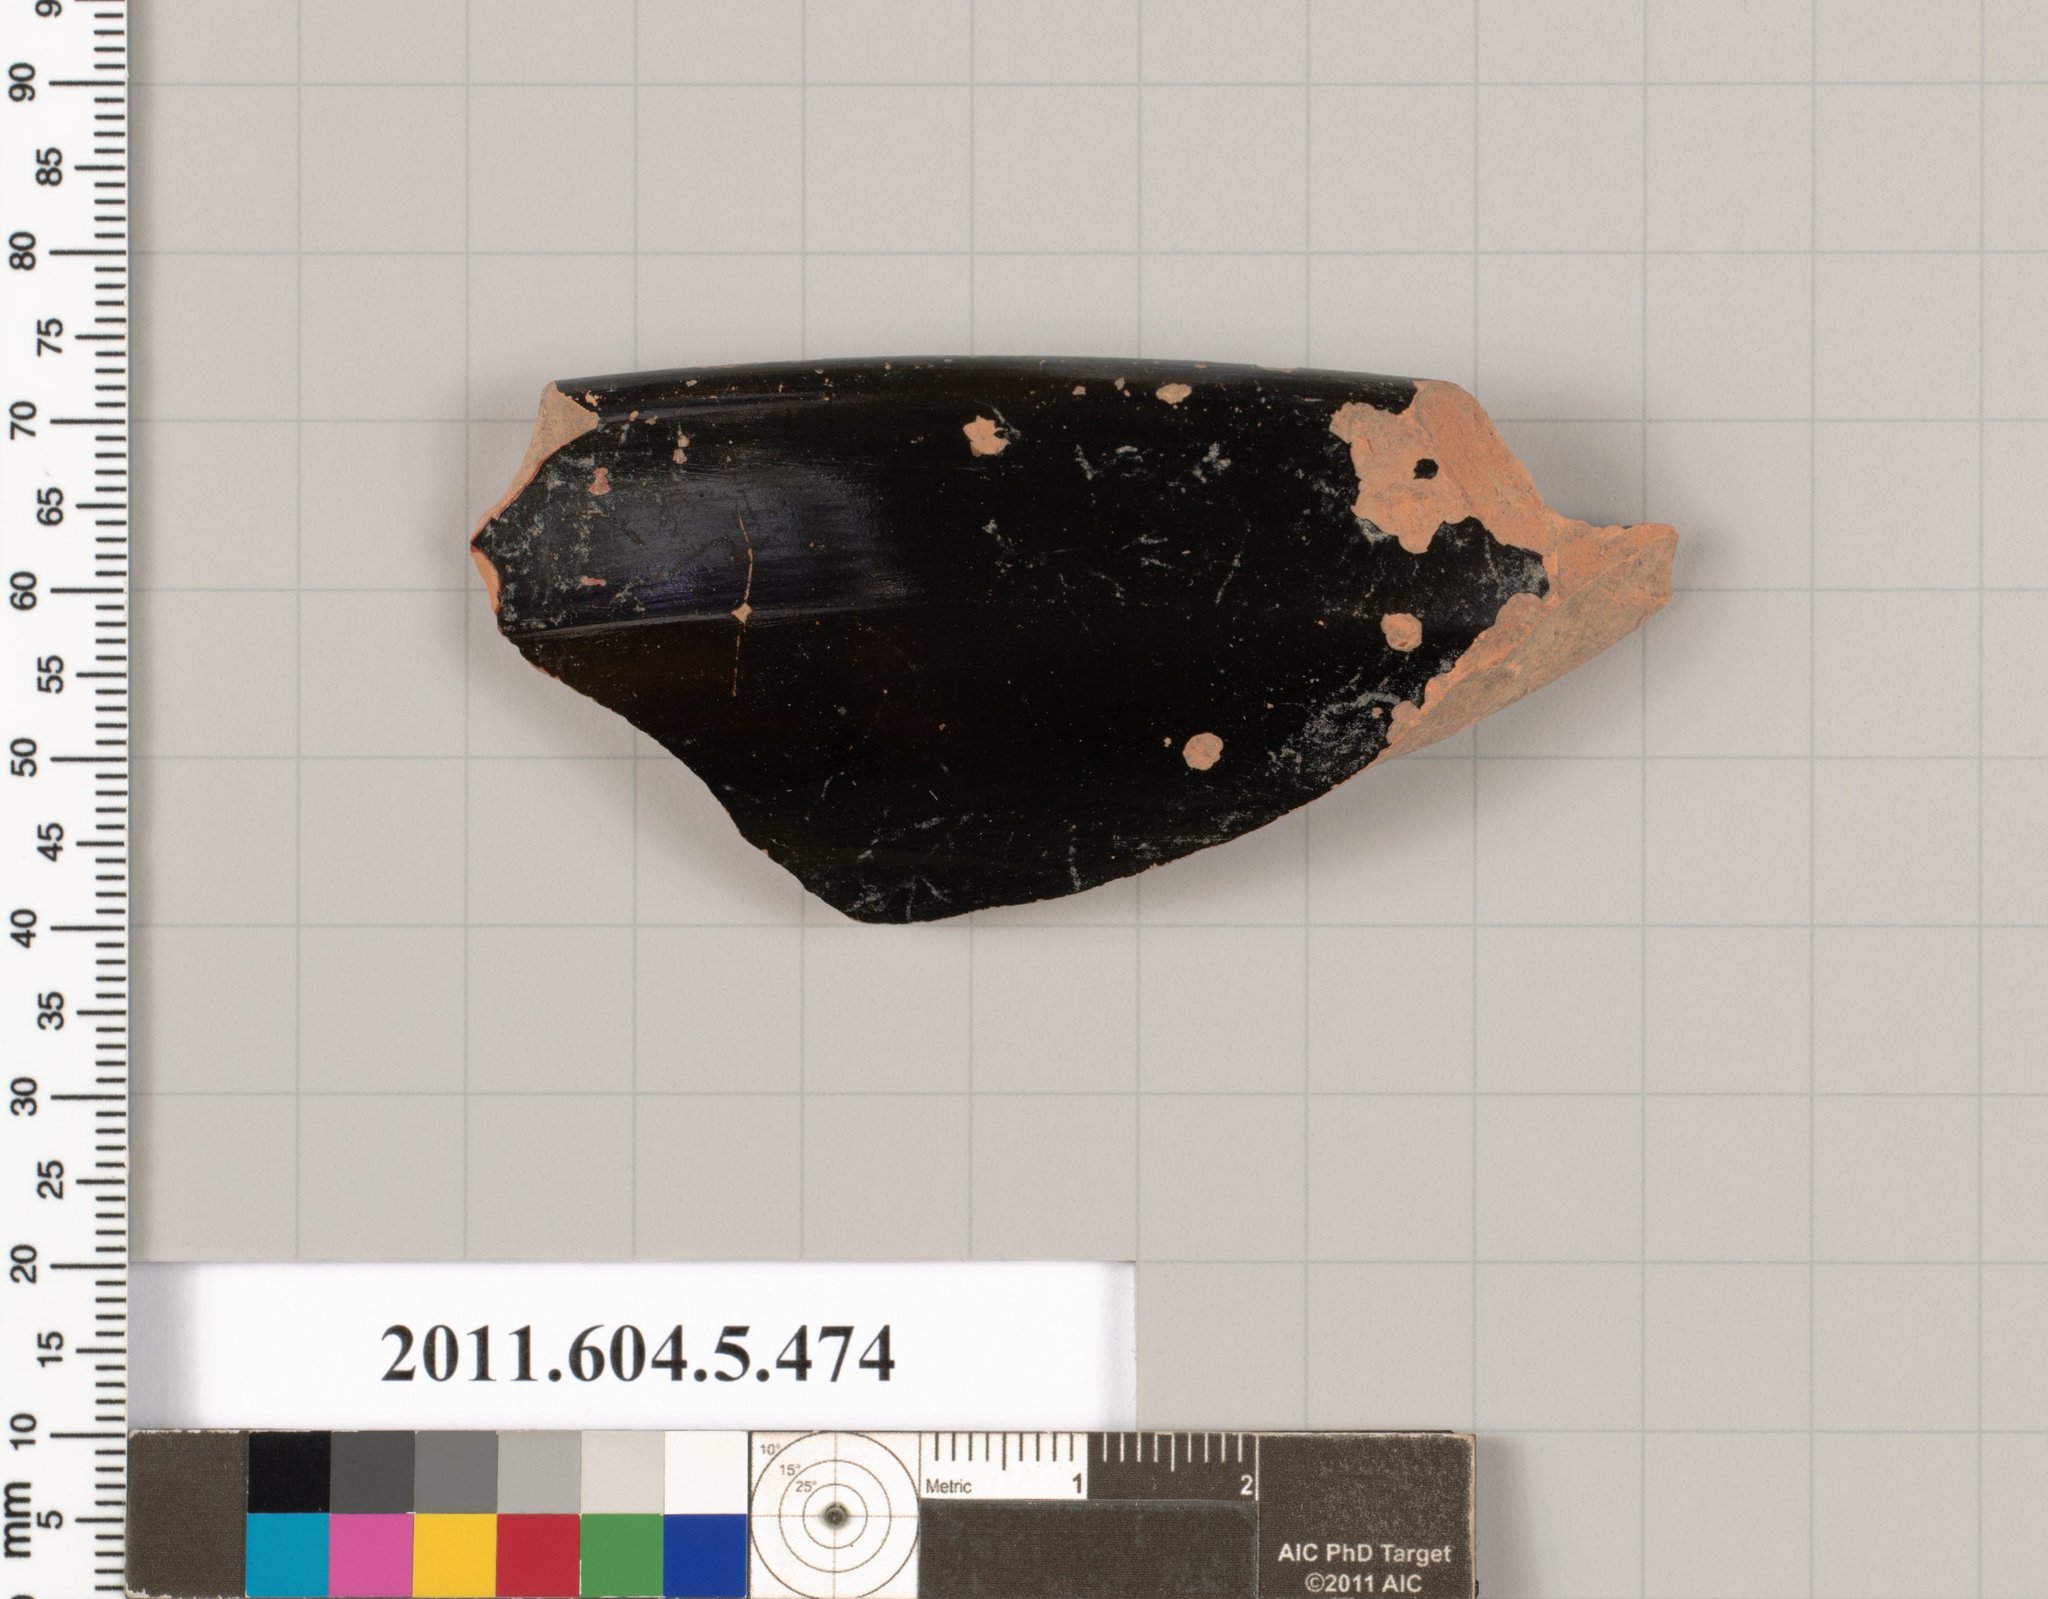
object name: kylix fragment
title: Terracotta rim fragment of a kylix (drinking cup)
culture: greek, attic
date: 600-401 BCE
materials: terracotta